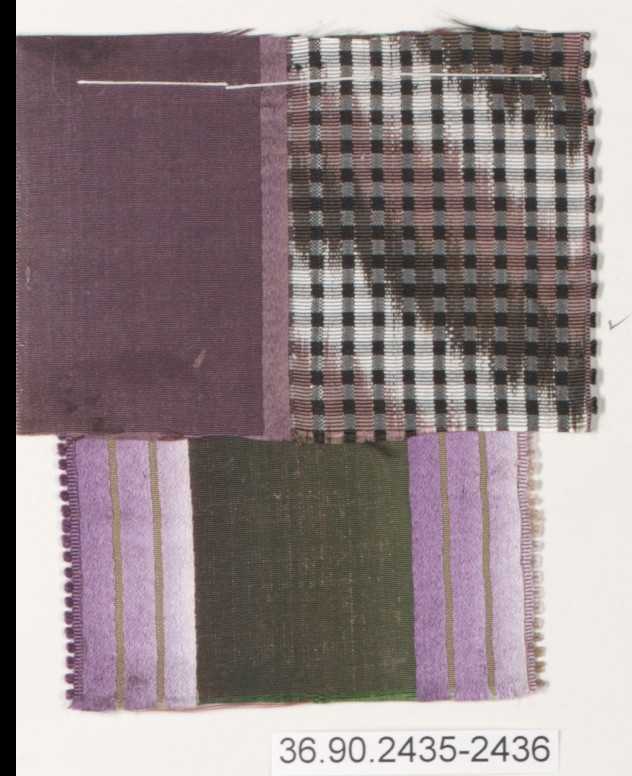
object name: ribbon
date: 1801-1900